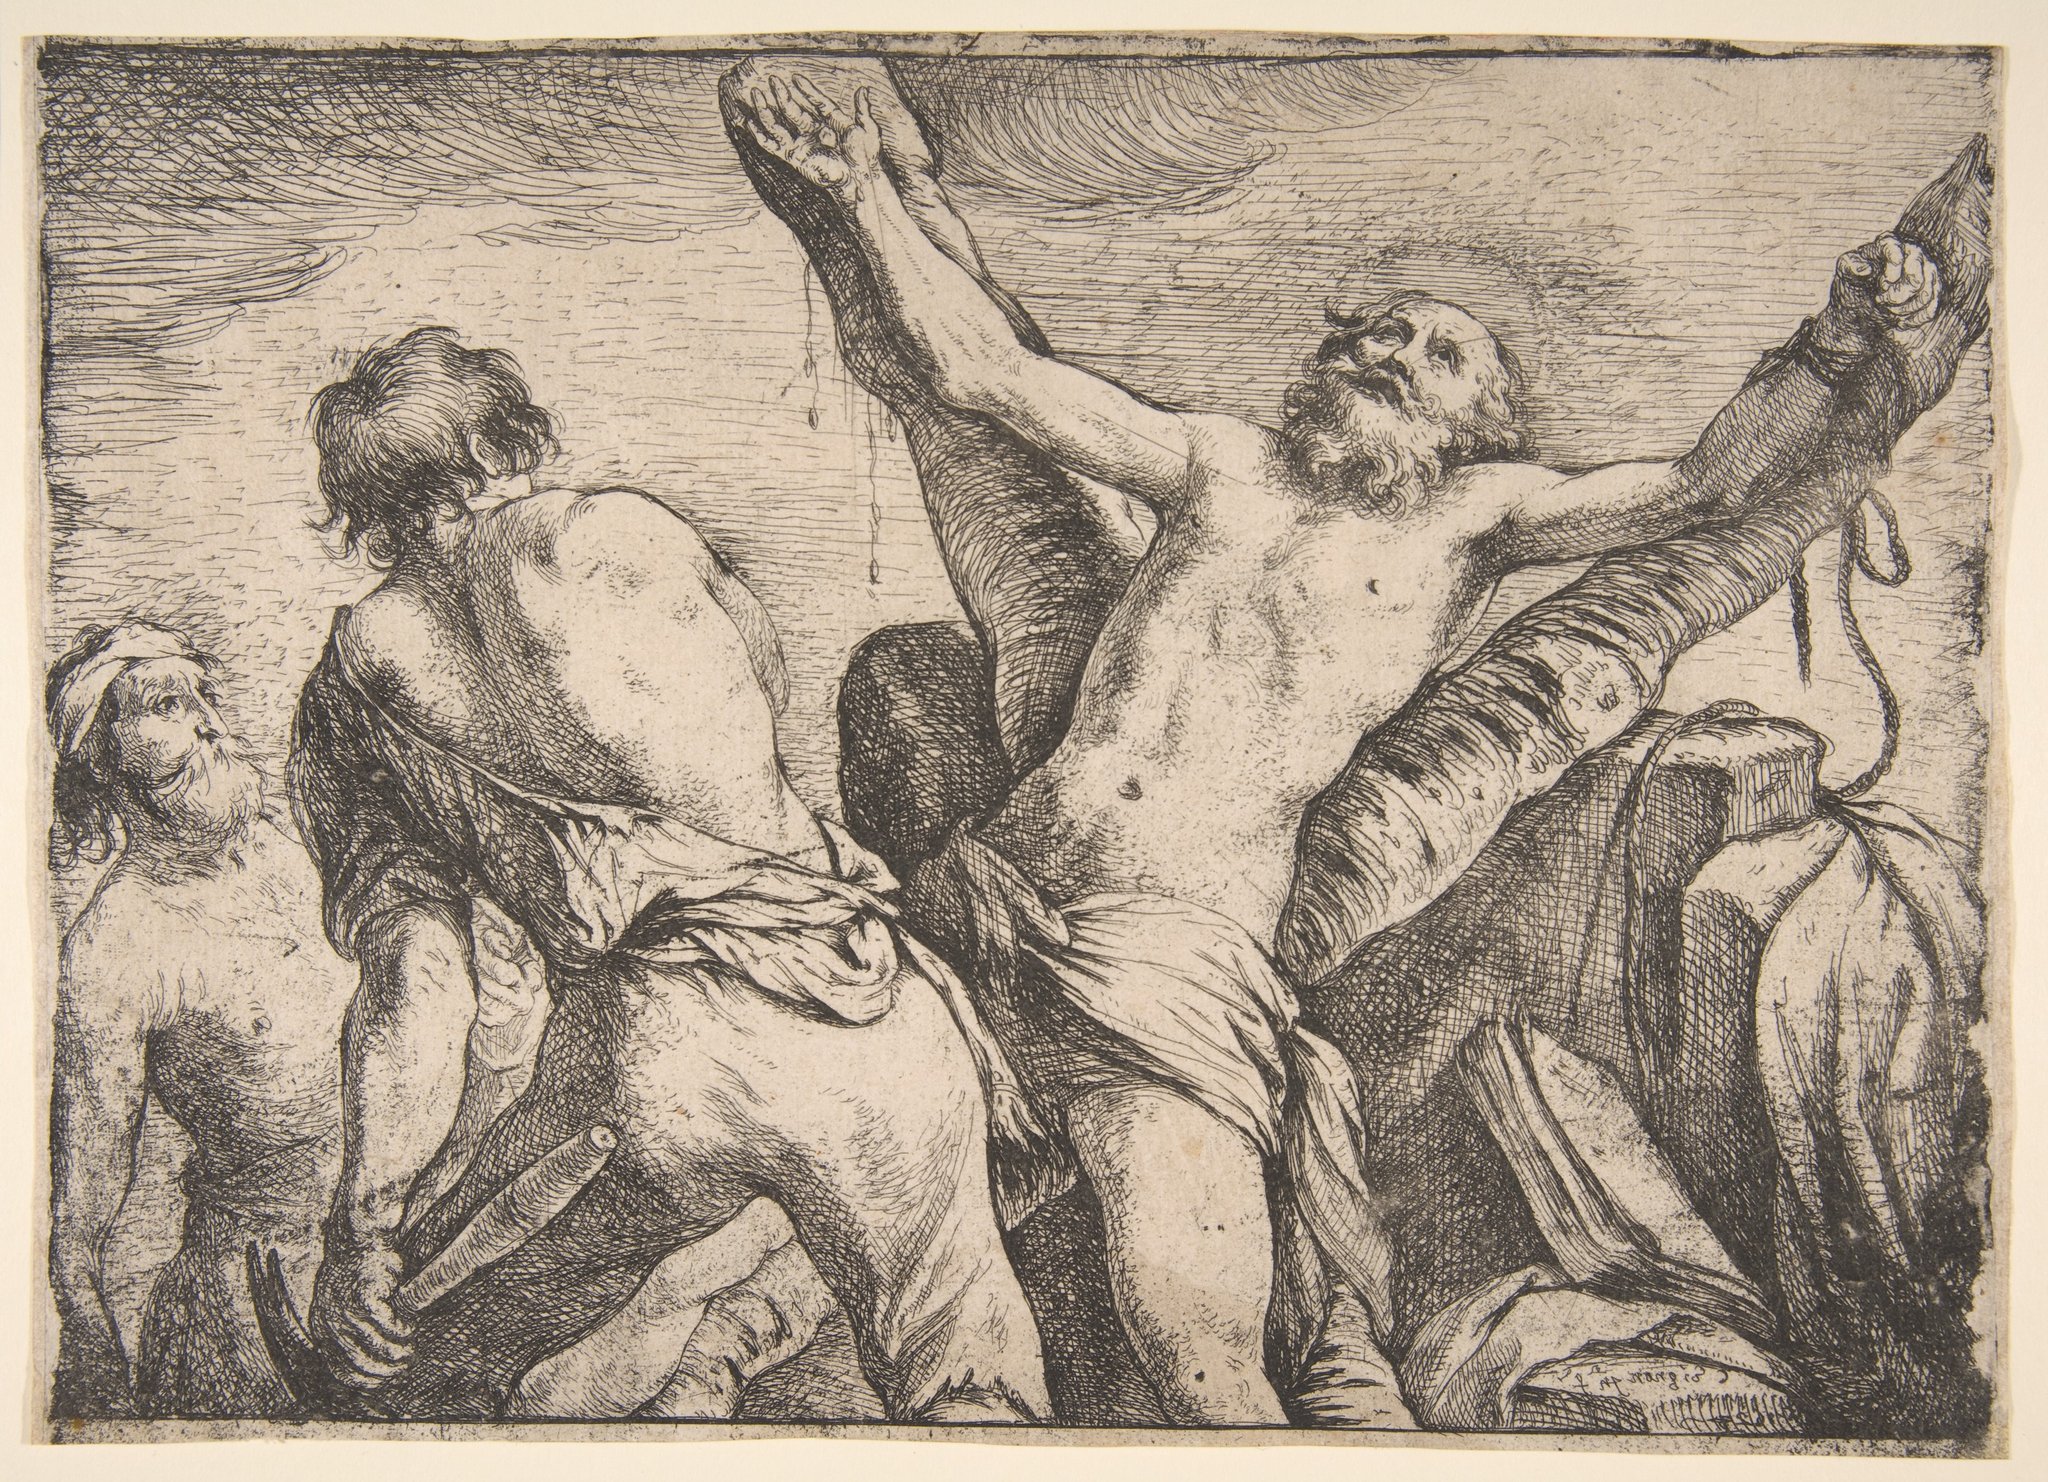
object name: print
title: The Martyrdom of Saint Andrew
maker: claude vignon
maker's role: artist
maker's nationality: french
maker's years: 1593-1670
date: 1623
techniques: etching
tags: suffering,men,saints